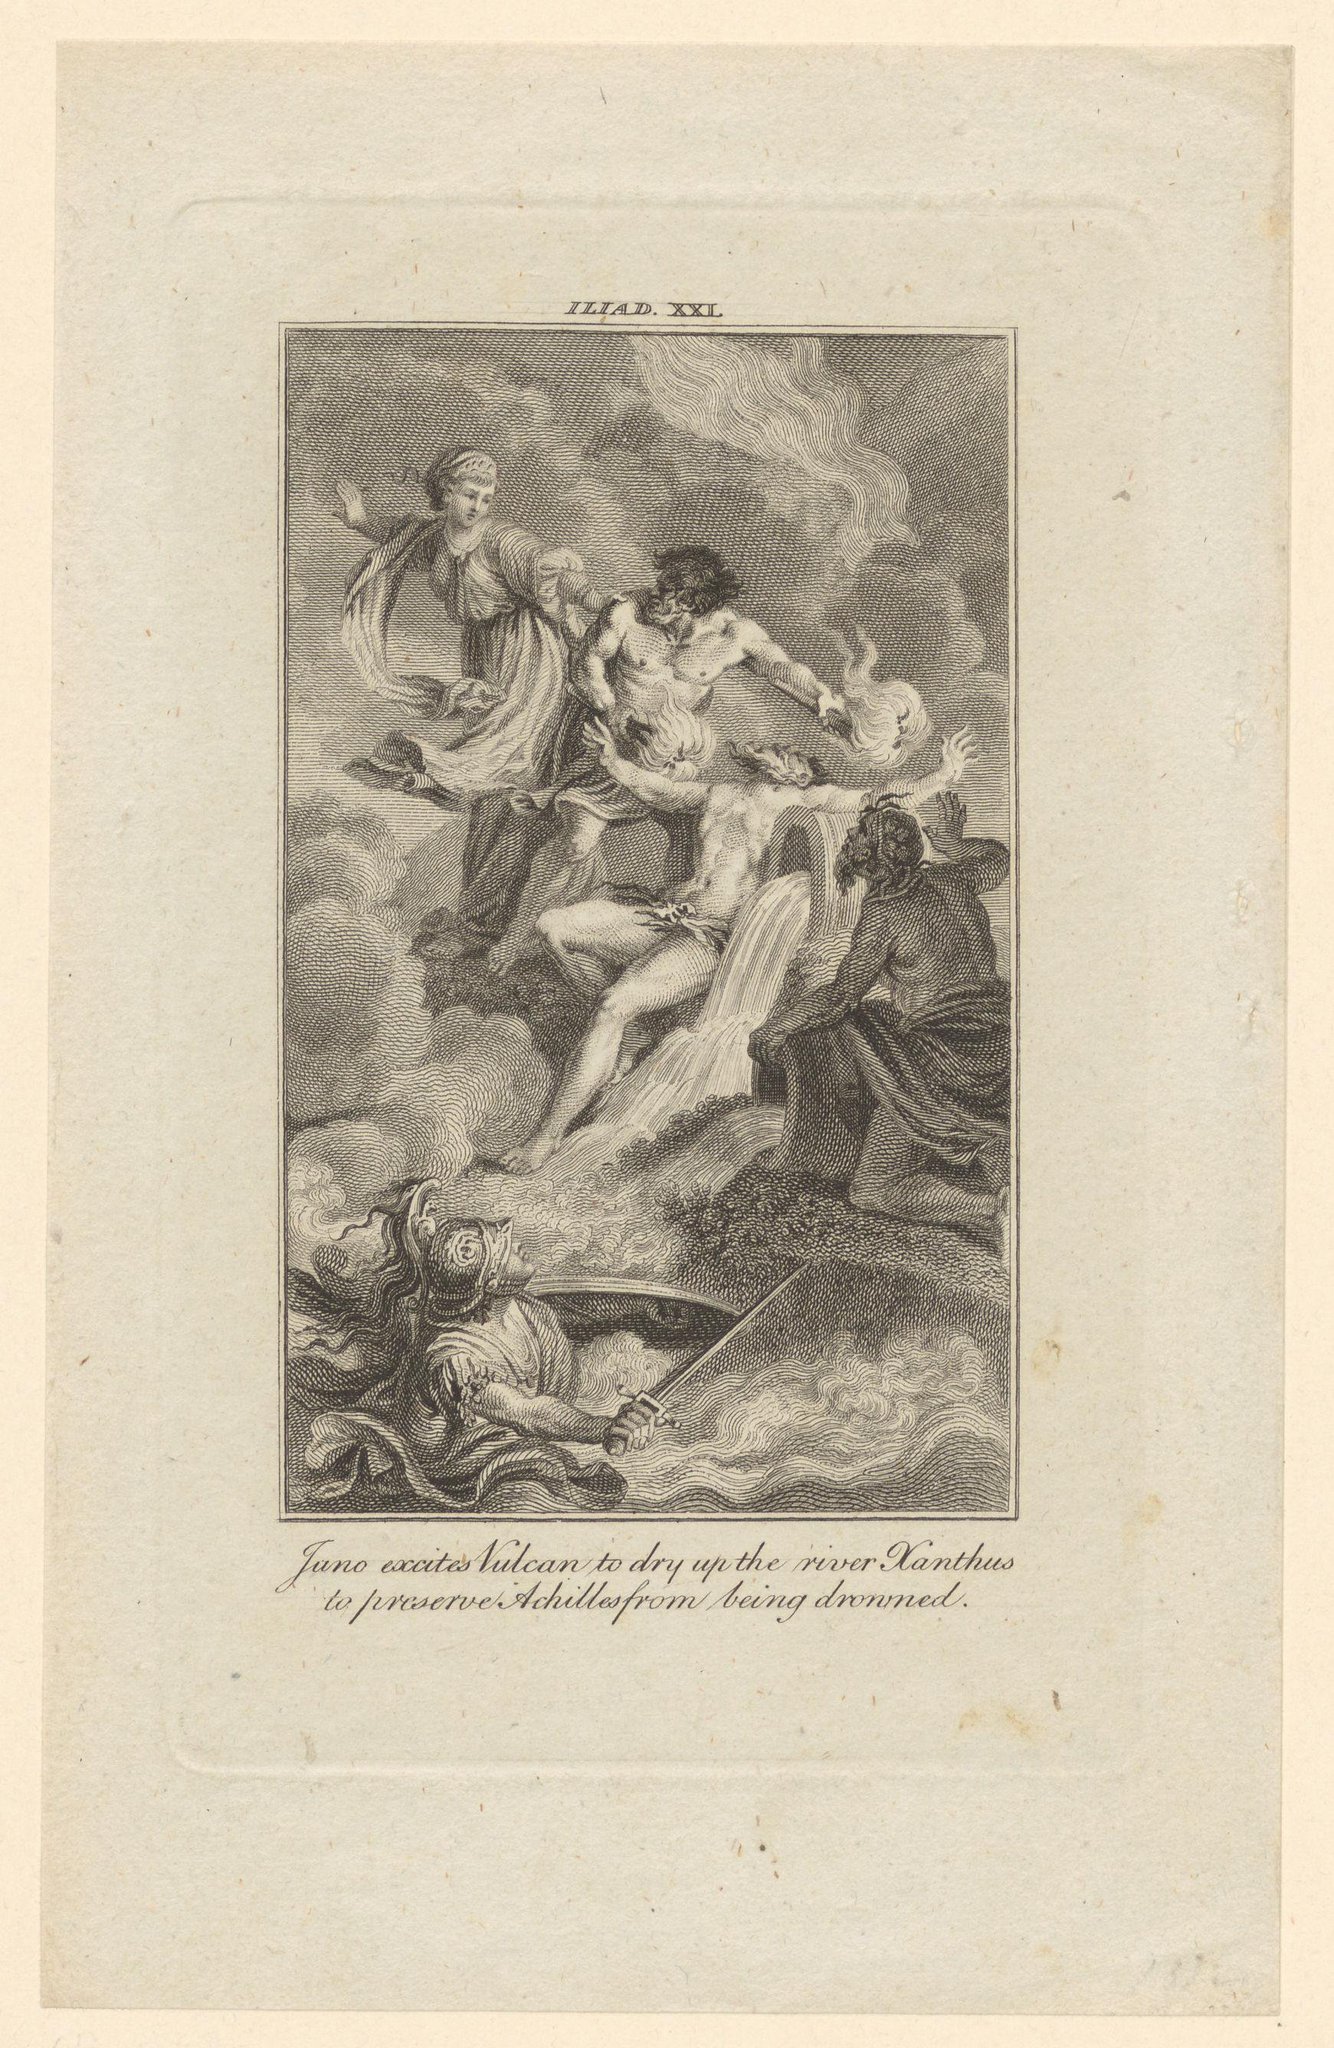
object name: print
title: Juno spoort Vulcanus aan de rivier Xanthus op te drogen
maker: f. cary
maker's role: print maker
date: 1750-1850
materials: paper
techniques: etching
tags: (story of) vulcan (hephaestus), achilles fights the river-gods scamander and simois; achilles is assisted by vulcan, who dries up the waters with scorching flames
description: Tekst in het Engels in de ondermarge. Deze voorstelling is gebaseerd op de verhalen in boek 25 van de Ilias door Homerus.